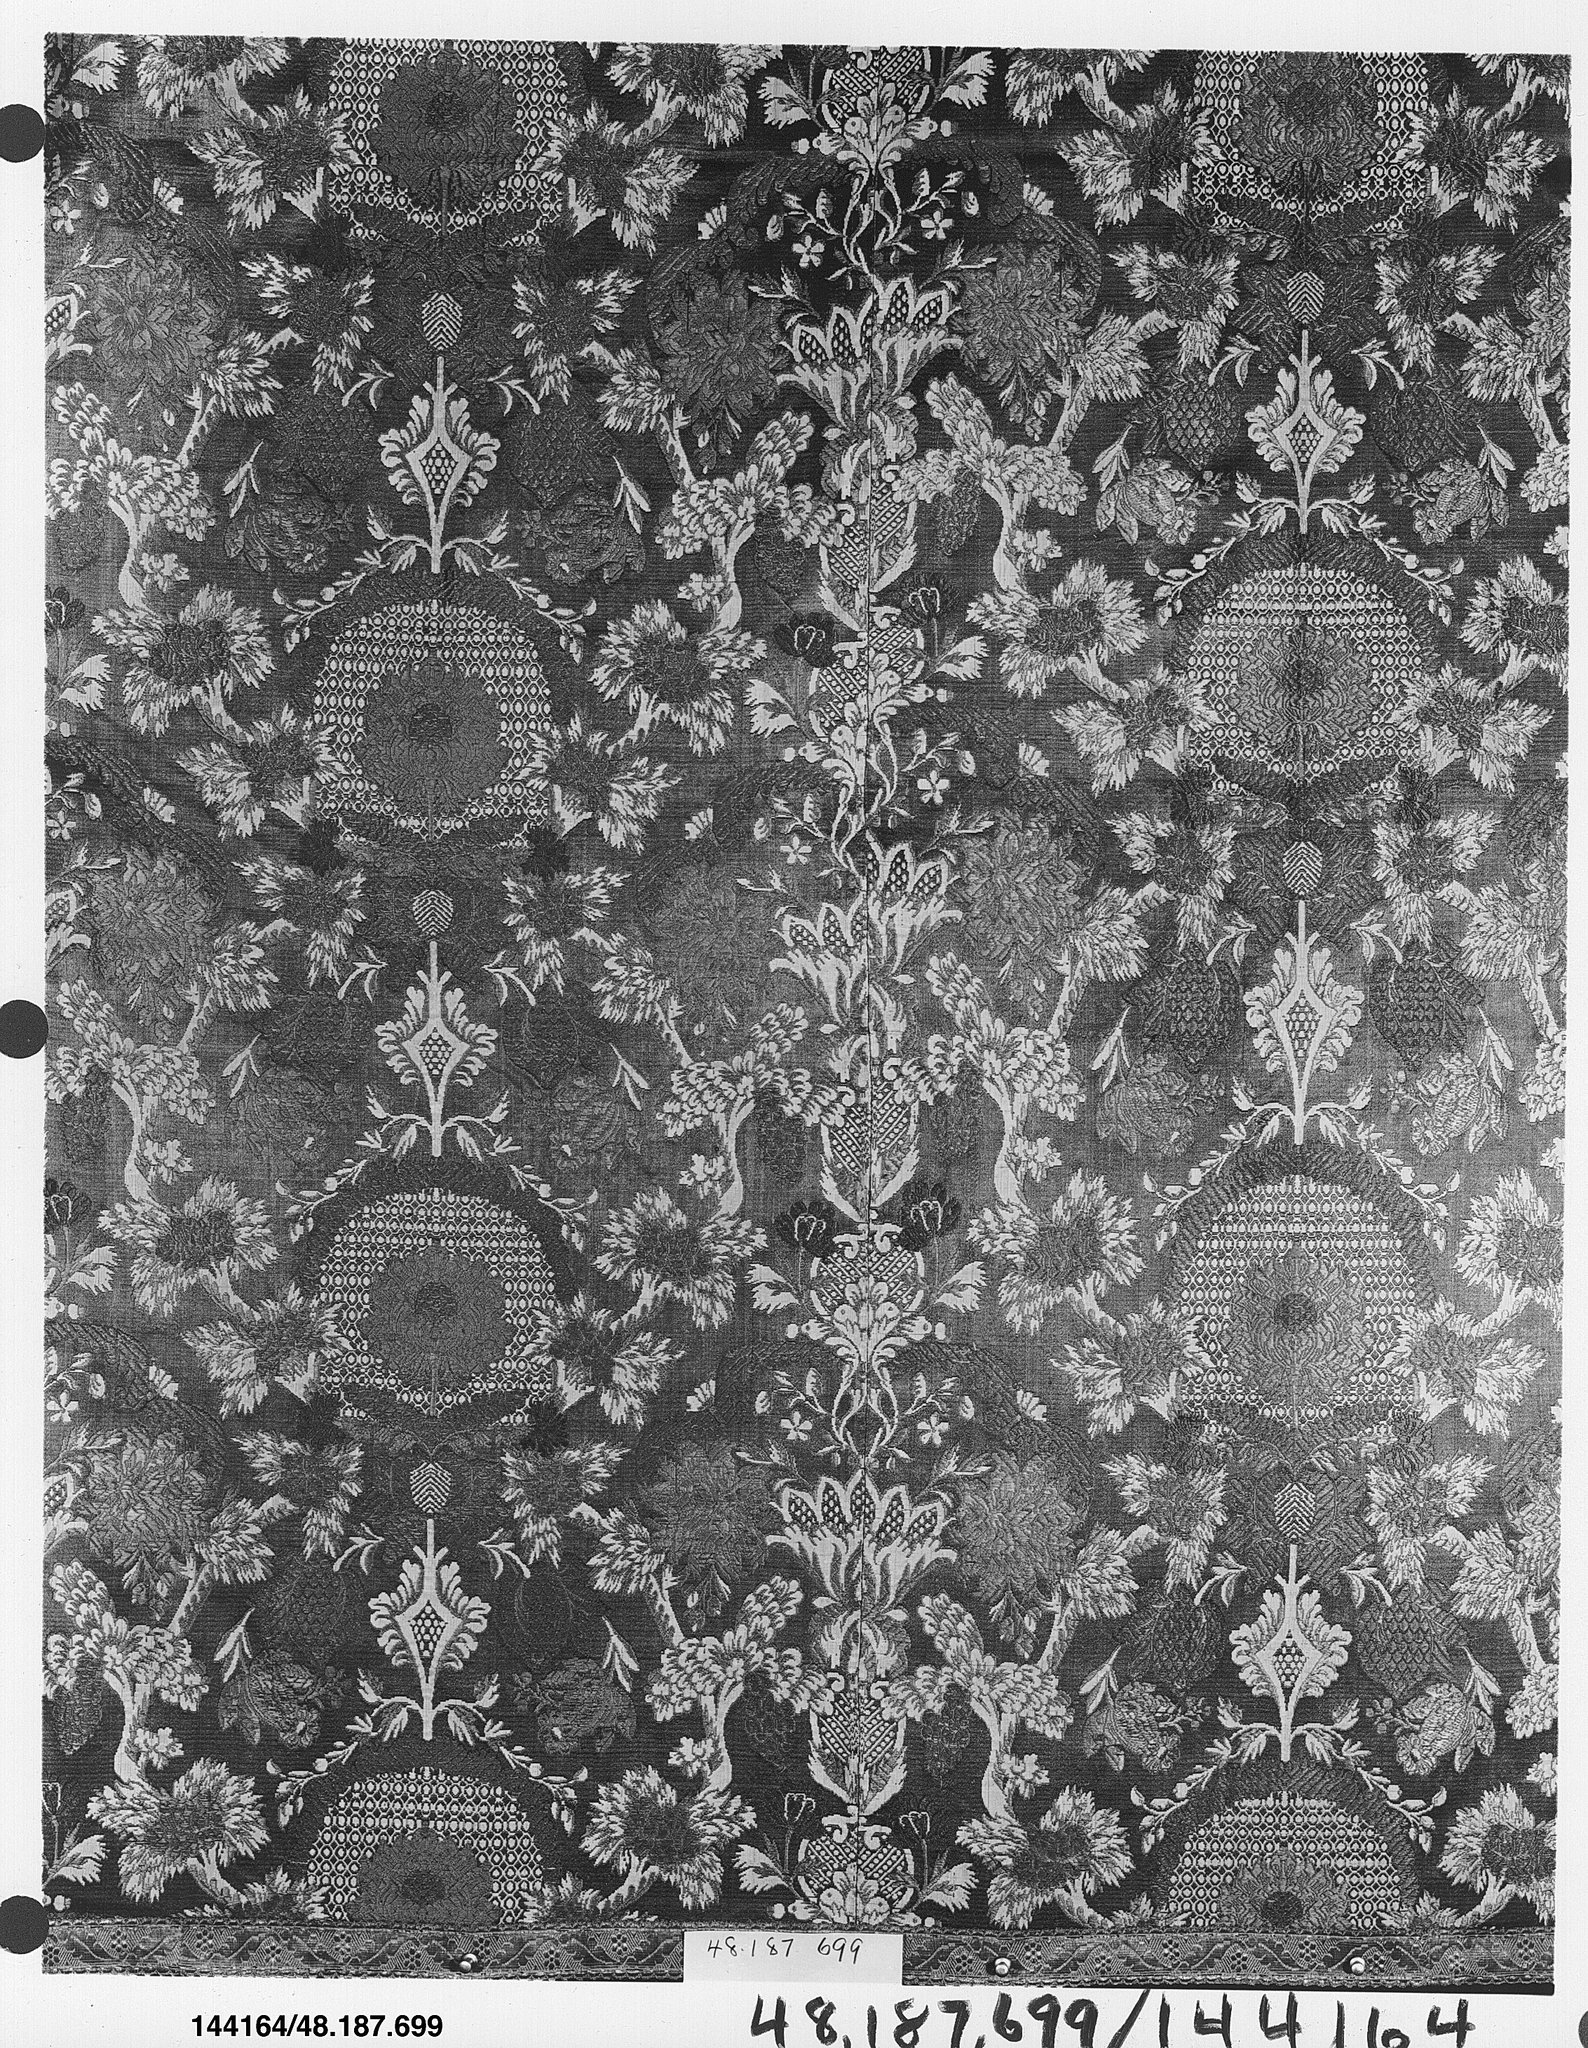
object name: piece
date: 1725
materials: metal thread, silk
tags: flowers